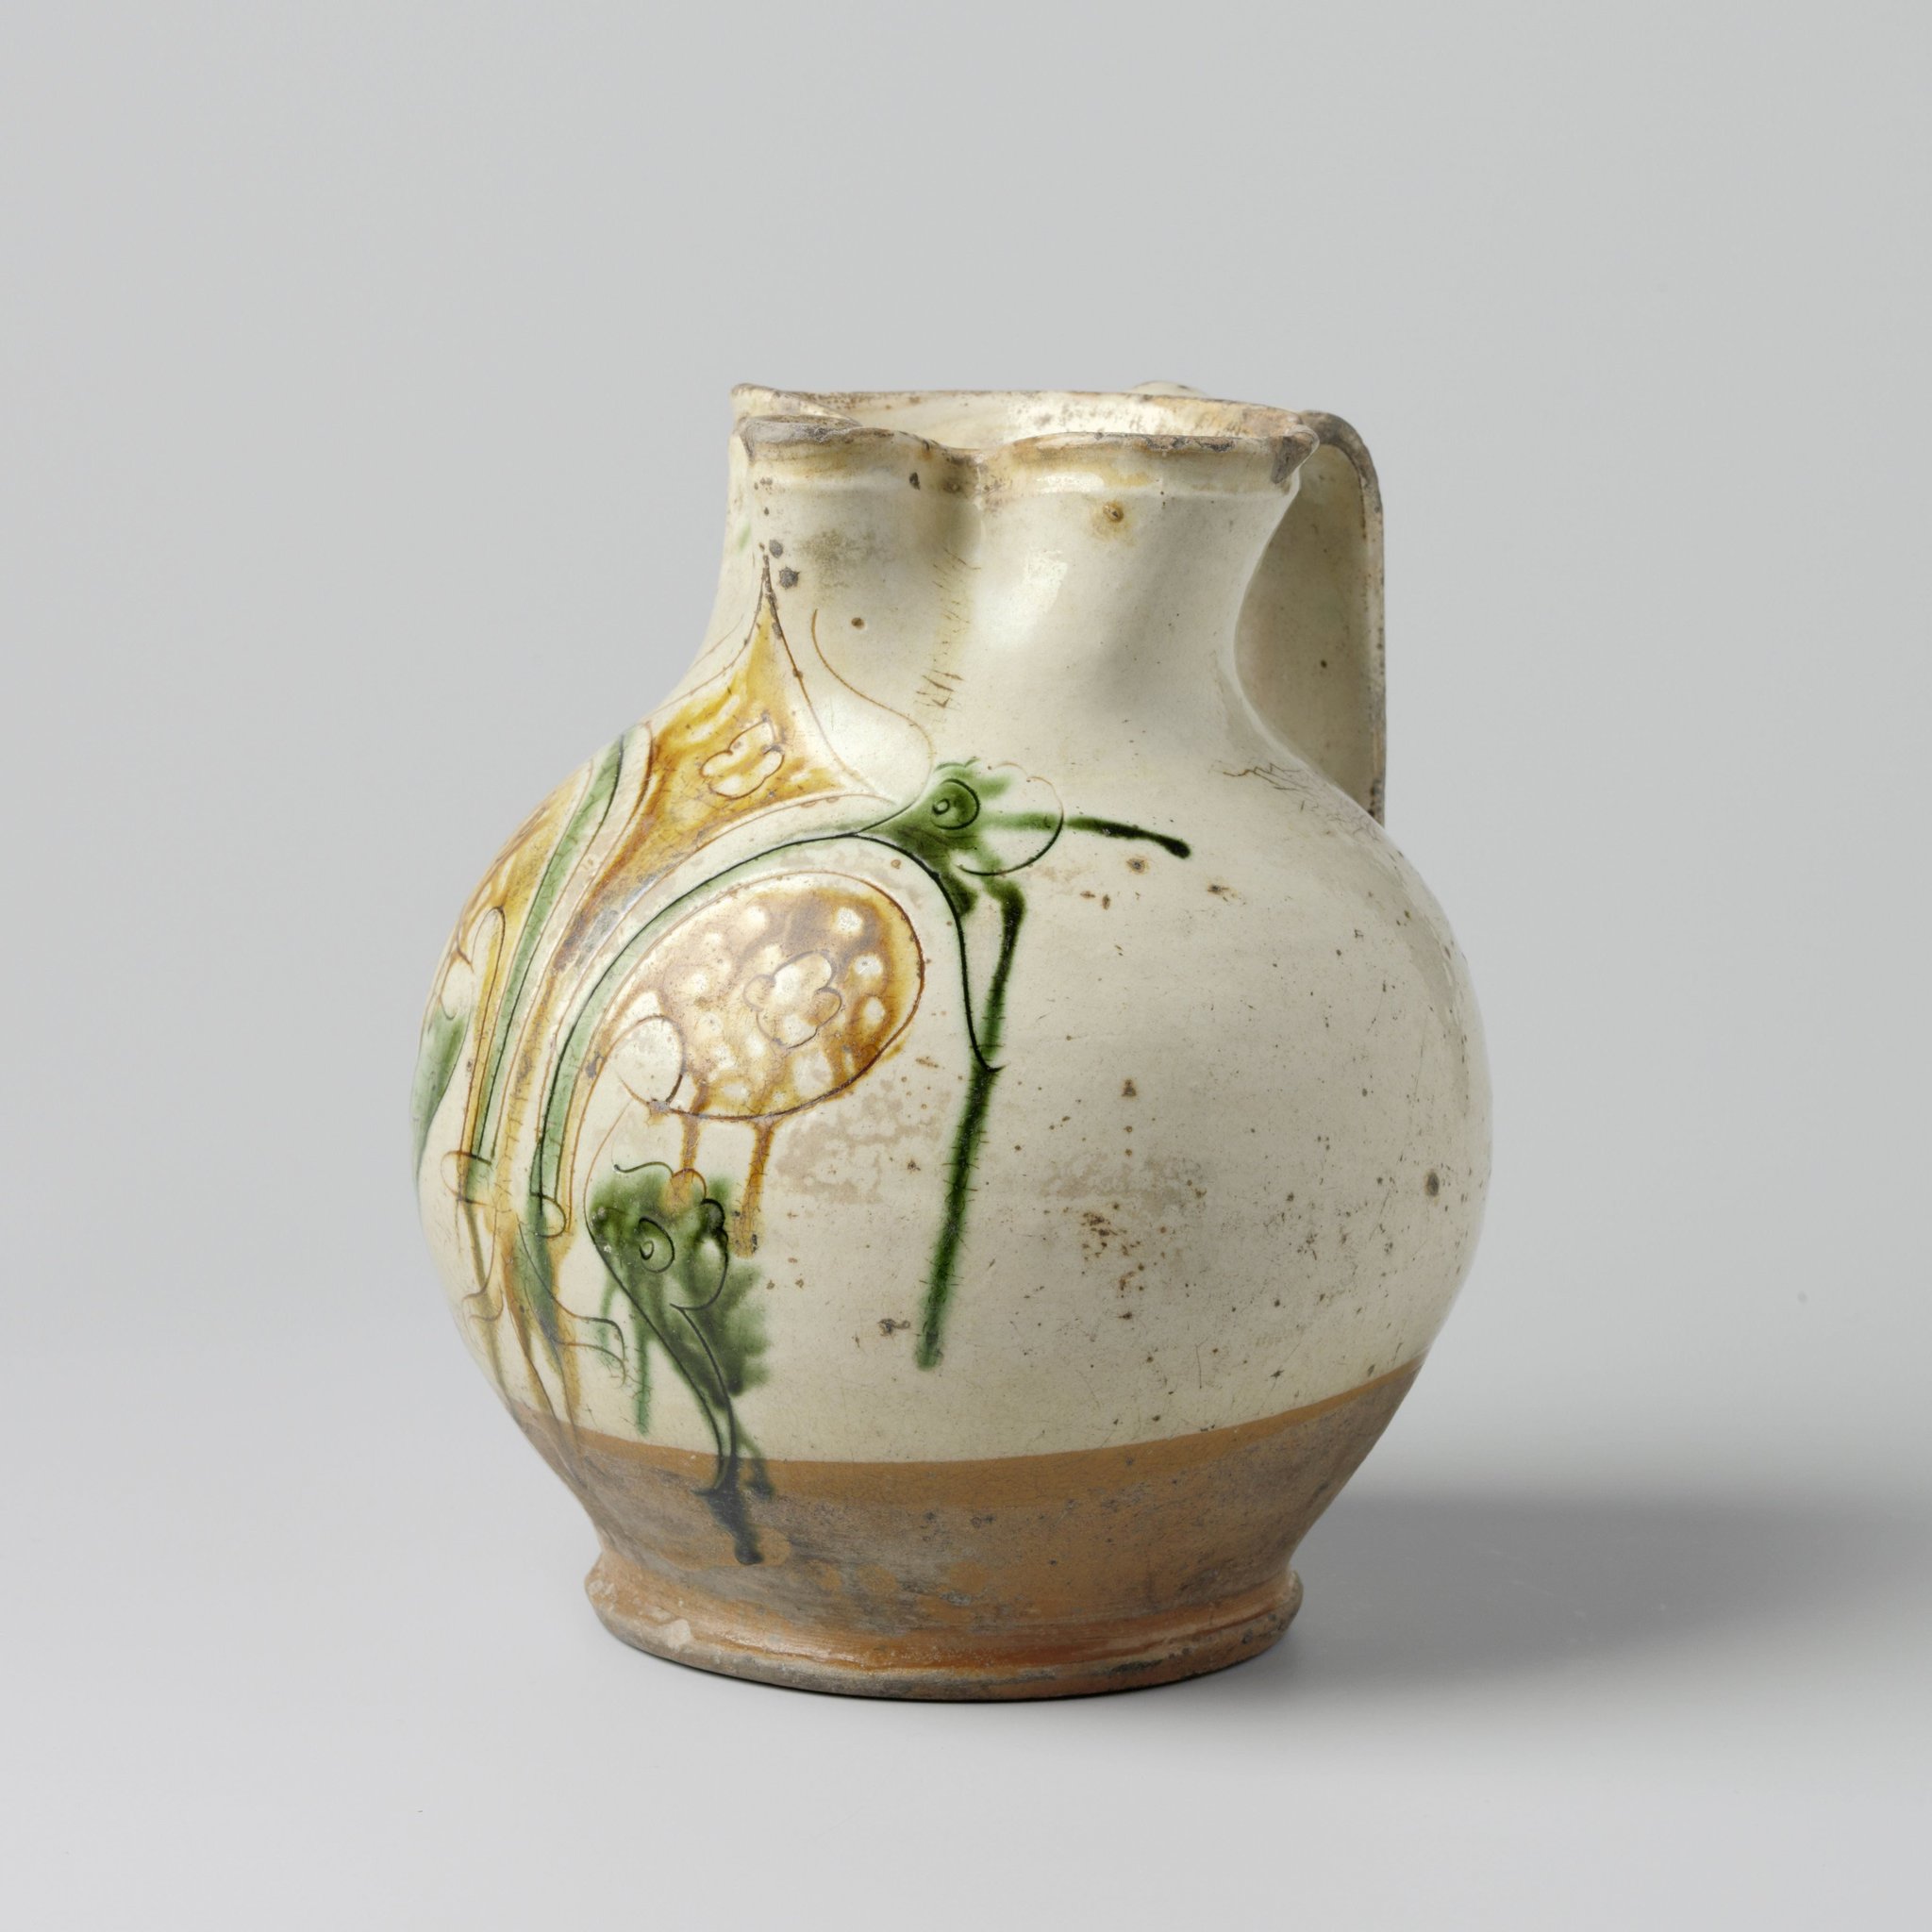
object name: ewer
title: Kan, bolvormig met ingeknepen tuit en breed, plat oor, veelkleurig beschilderd met Florentijnse lelie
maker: Anonymous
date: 1450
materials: earthenware, glaze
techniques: maiolica, painted, polychromy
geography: bologna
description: Jug. Lead-glazed earthenware, with decoration incised through slip (sgraffiato). Bologna area, c. 1450 - 1480.